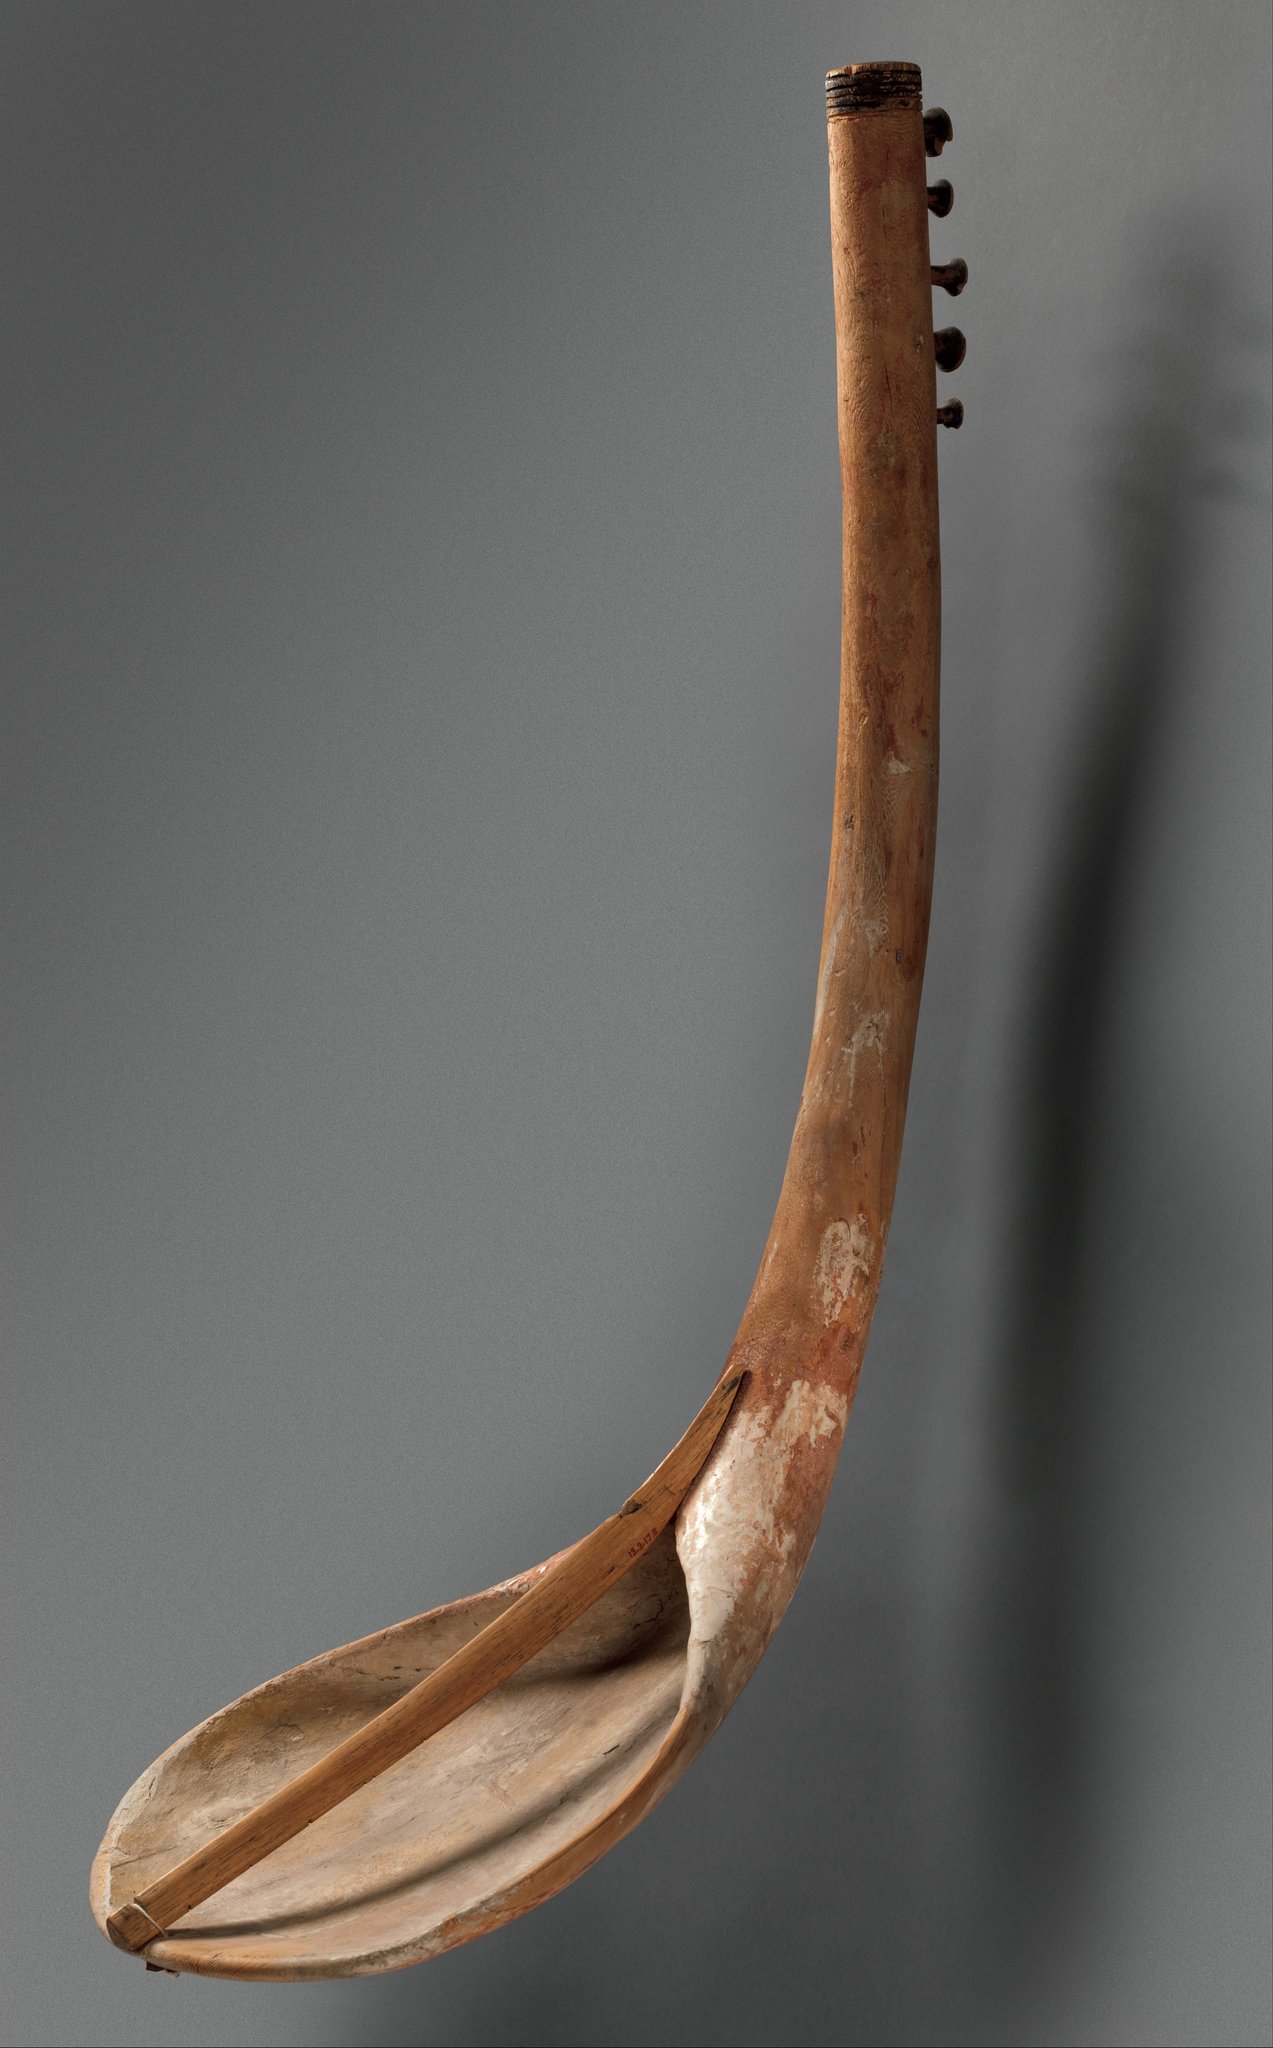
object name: music, harp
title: Bow harp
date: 2030-1640 BCE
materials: paint, wood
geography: egypt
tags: musical instruments